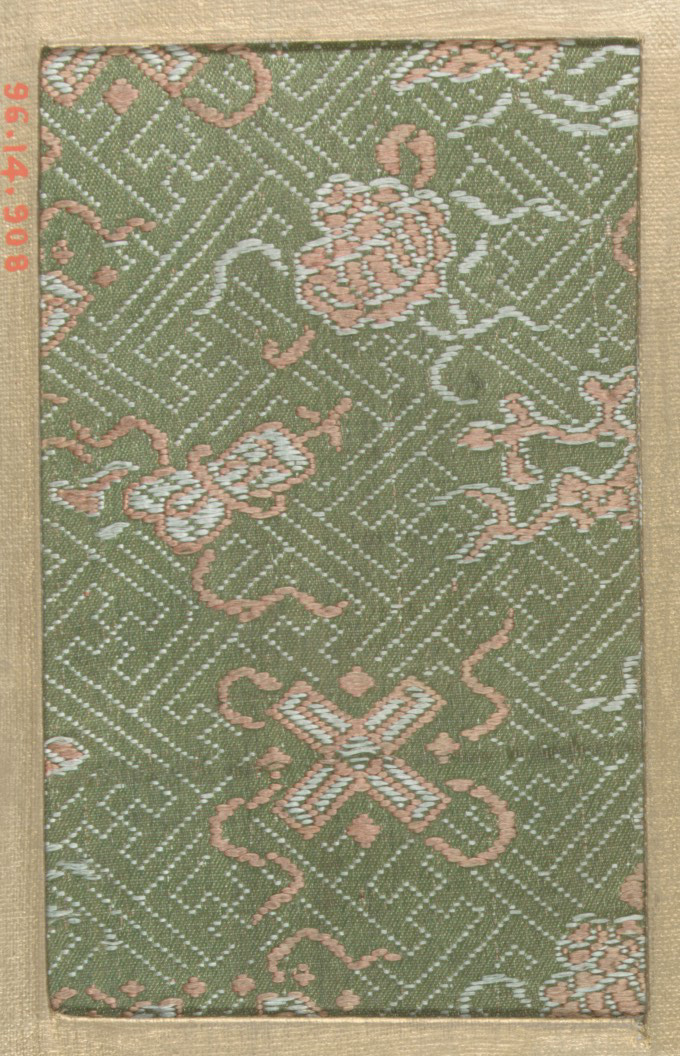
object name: piece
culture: japanese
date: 1701-1900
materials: silk